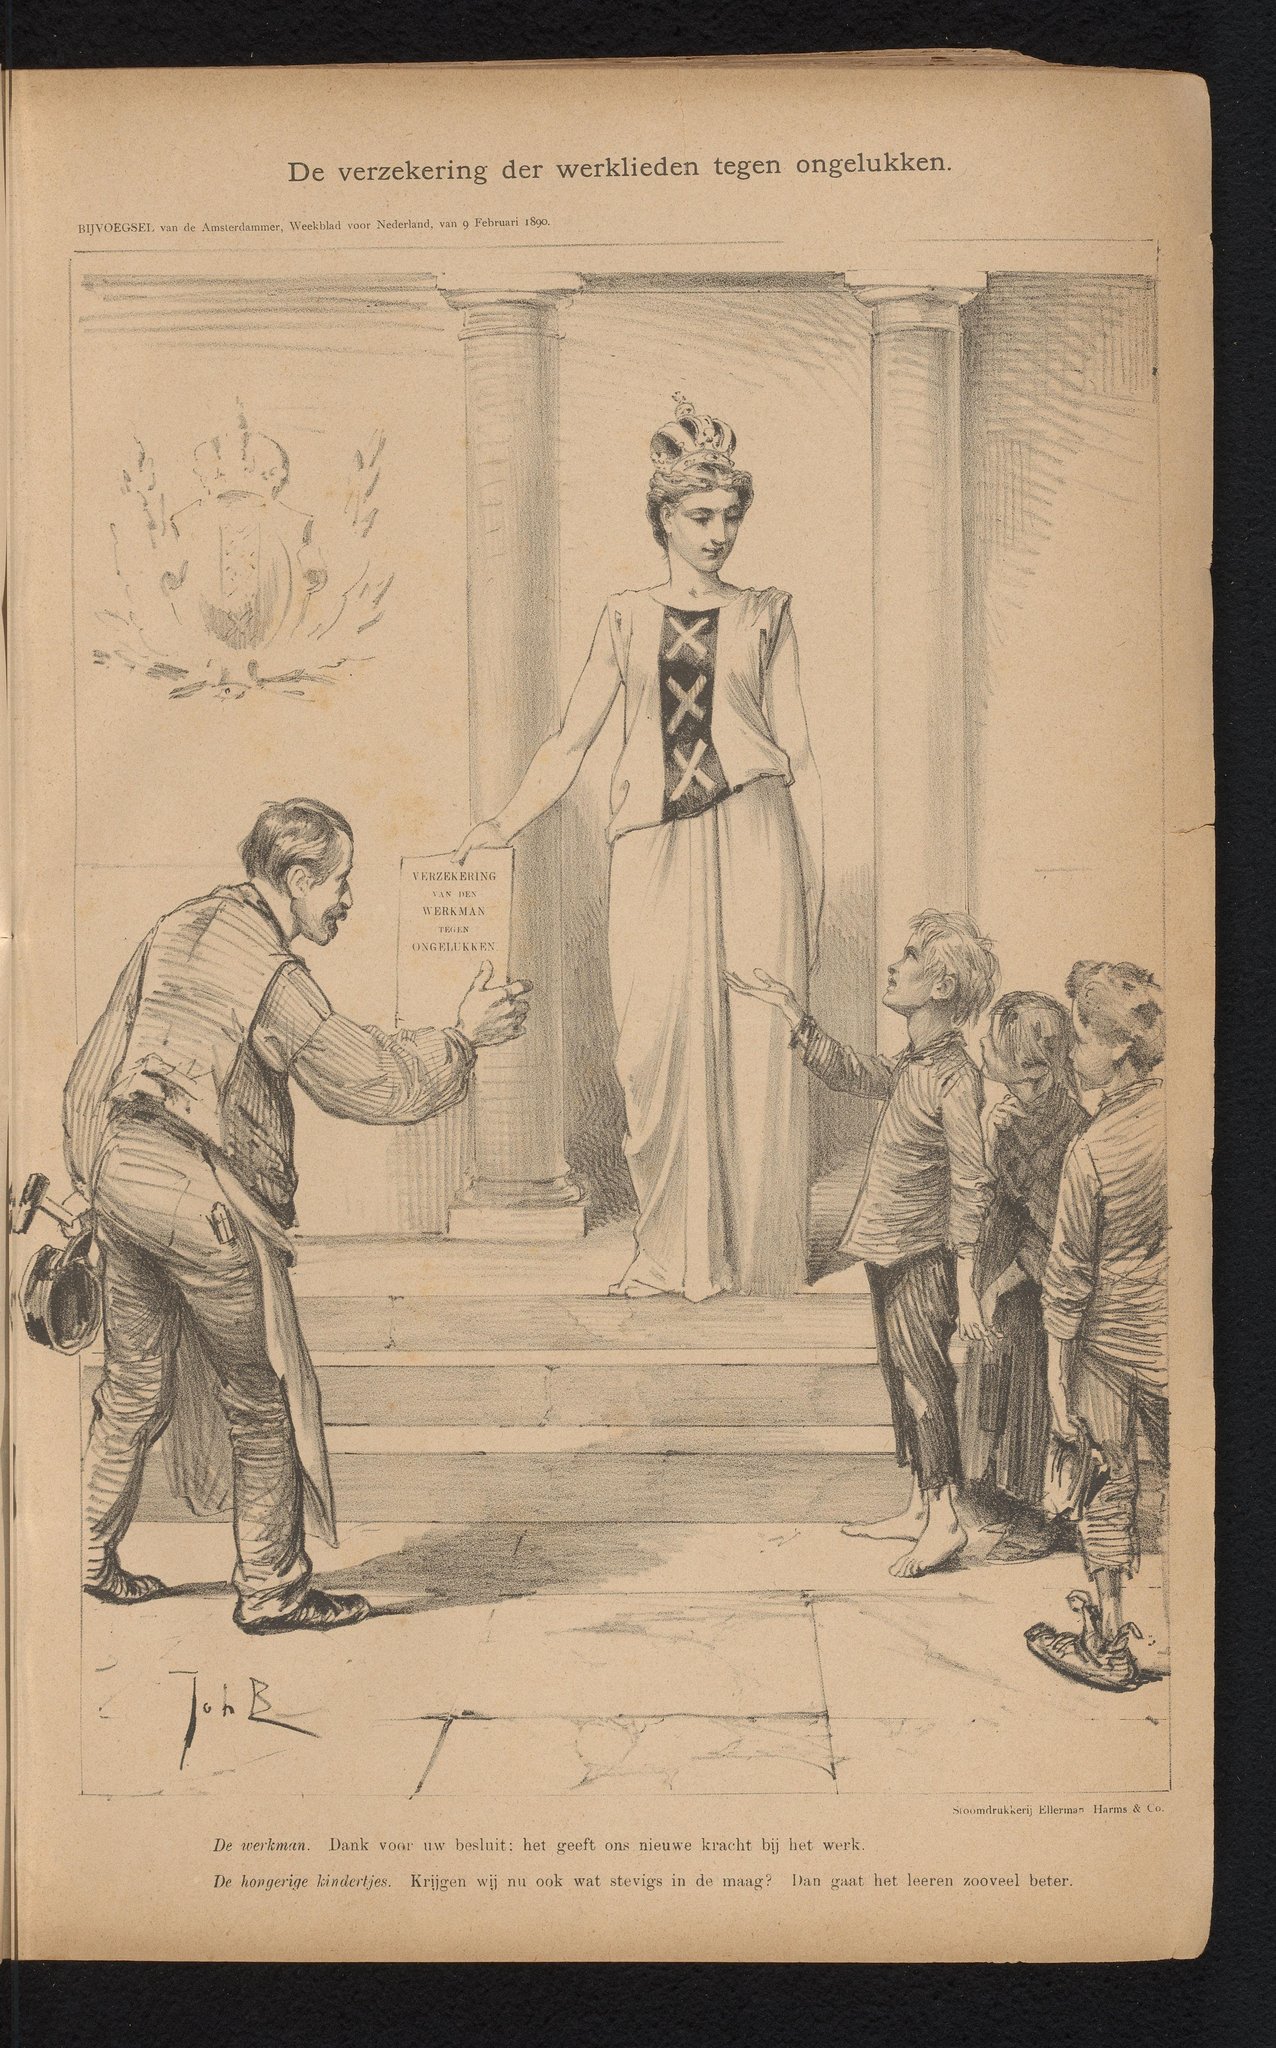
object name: print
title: De verzekering der werklieden tegen ongelukken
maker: johan braakensiek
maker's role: draughtsman, print maker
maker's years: 1858-1940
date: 1890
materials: paper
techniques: lithograph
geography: amsterdam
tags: hunger, personification of a city, town-patron(ess), working class, labourers, beggar, the poor, amsterdam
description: Een werkman krijgt van de Amsterdamse stedenmaagd een bewijs van verzekering aangereikt. Een groep arme kinderen vraagt om iets te eten zodat ze beter kunnen leren.